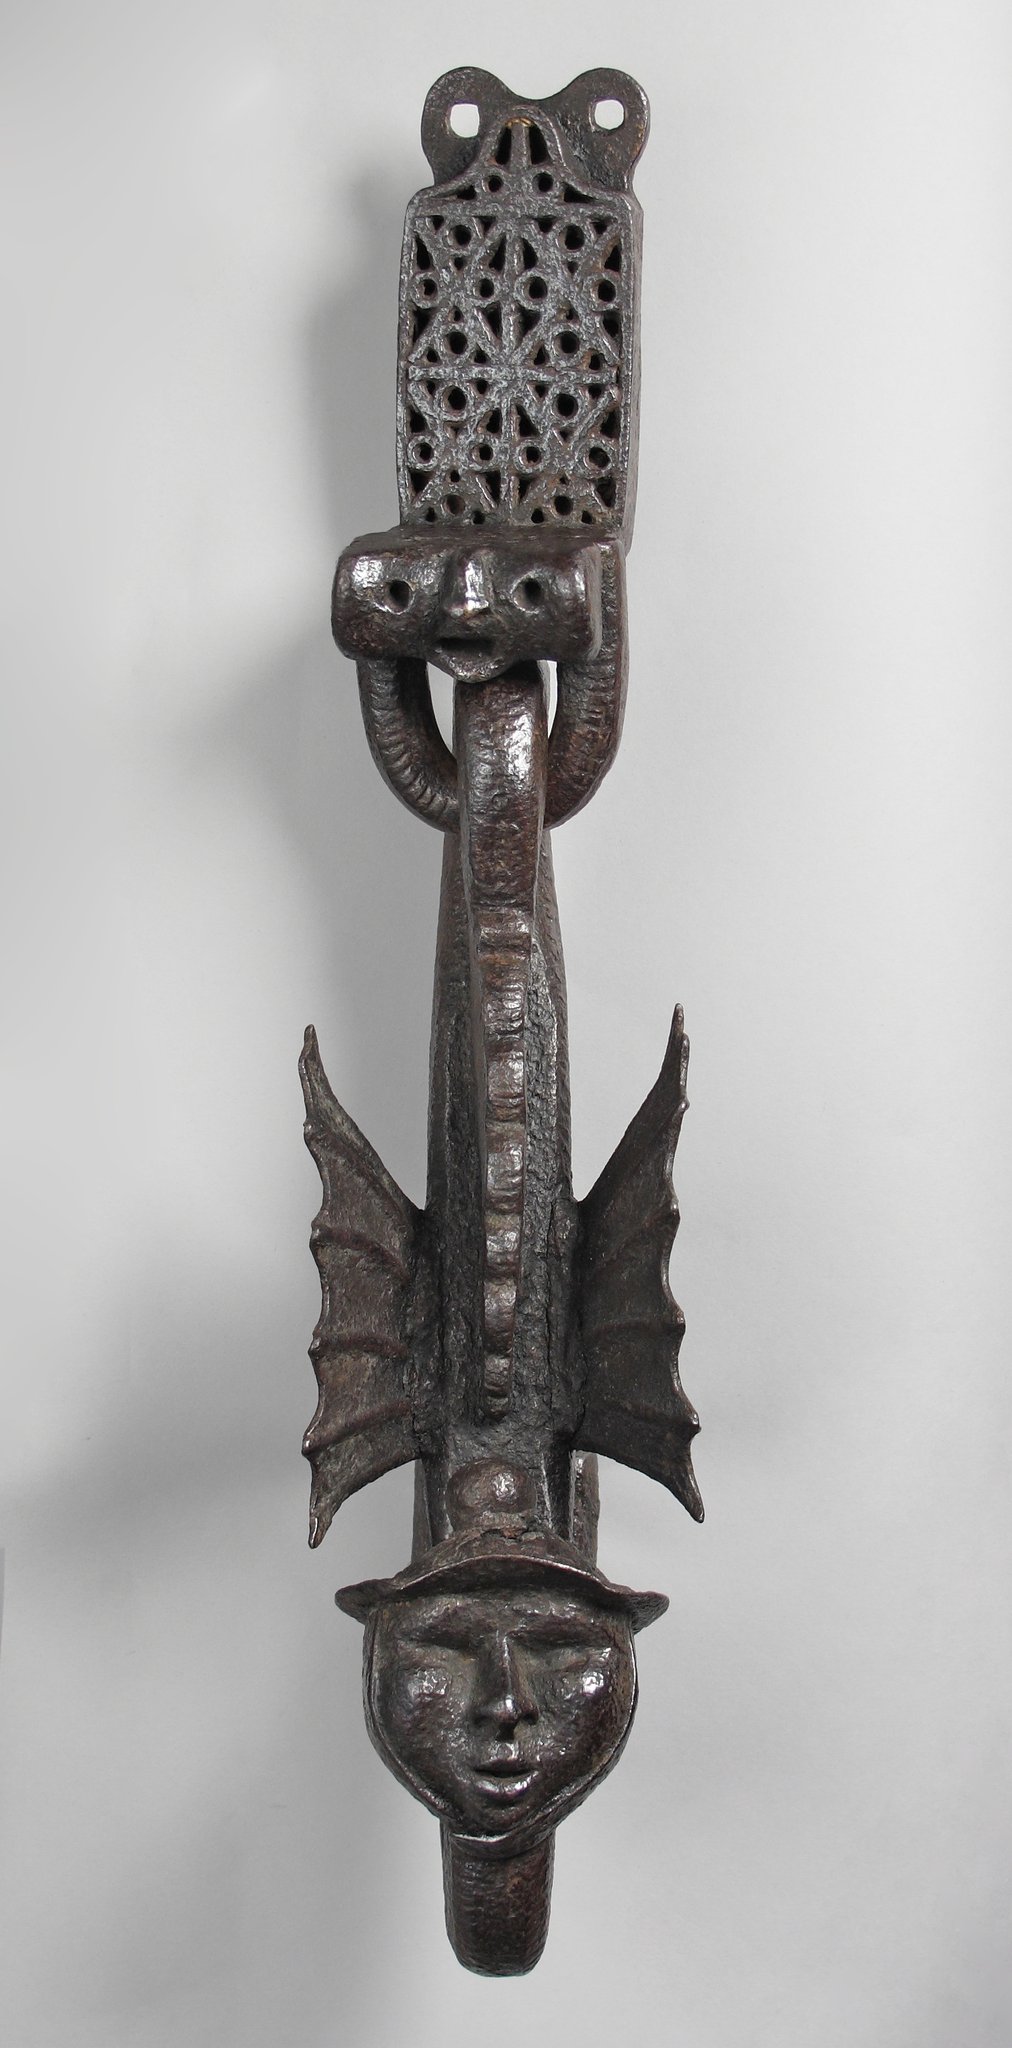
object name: door knocker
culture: european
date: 1401-1600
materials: iron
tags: faces